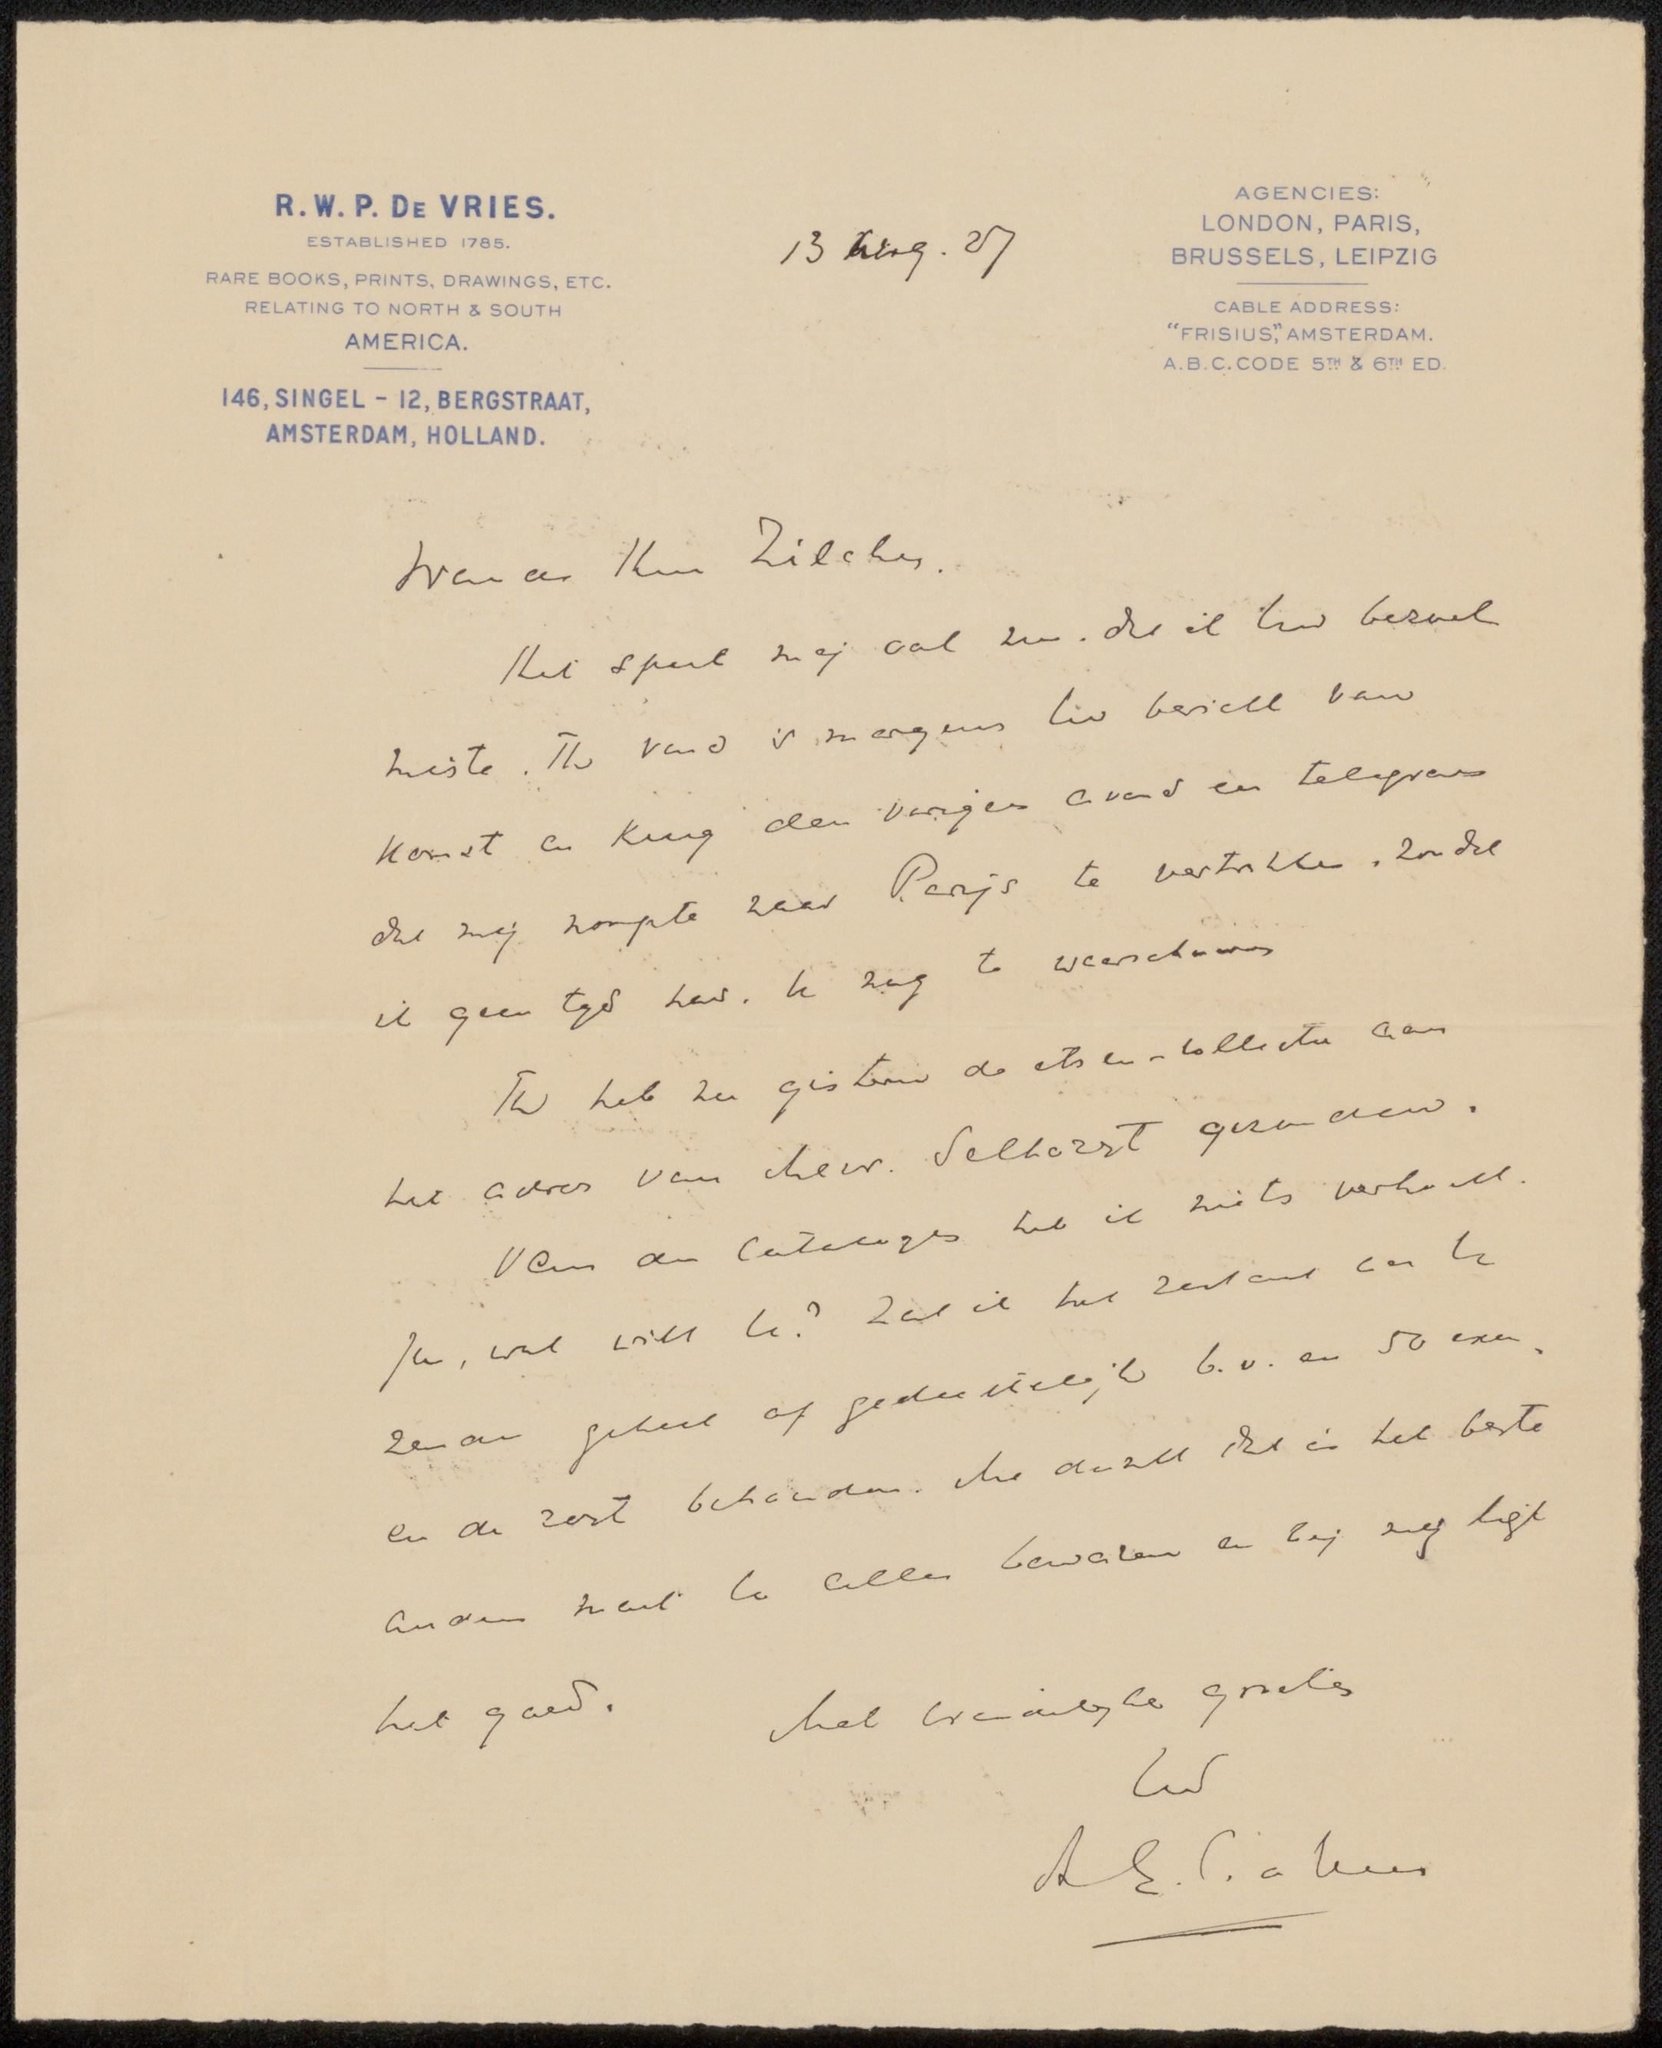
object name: letter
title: Brief aan Philip Zilcken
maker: Anonymous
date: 1927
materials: ink, paper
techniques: pen, printing, writing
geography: amsterdam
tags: the hague, painter, draughtsman, philip zilcken, the graphic arts, printed matter, paris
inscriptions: collector's mark: ‘RPK’